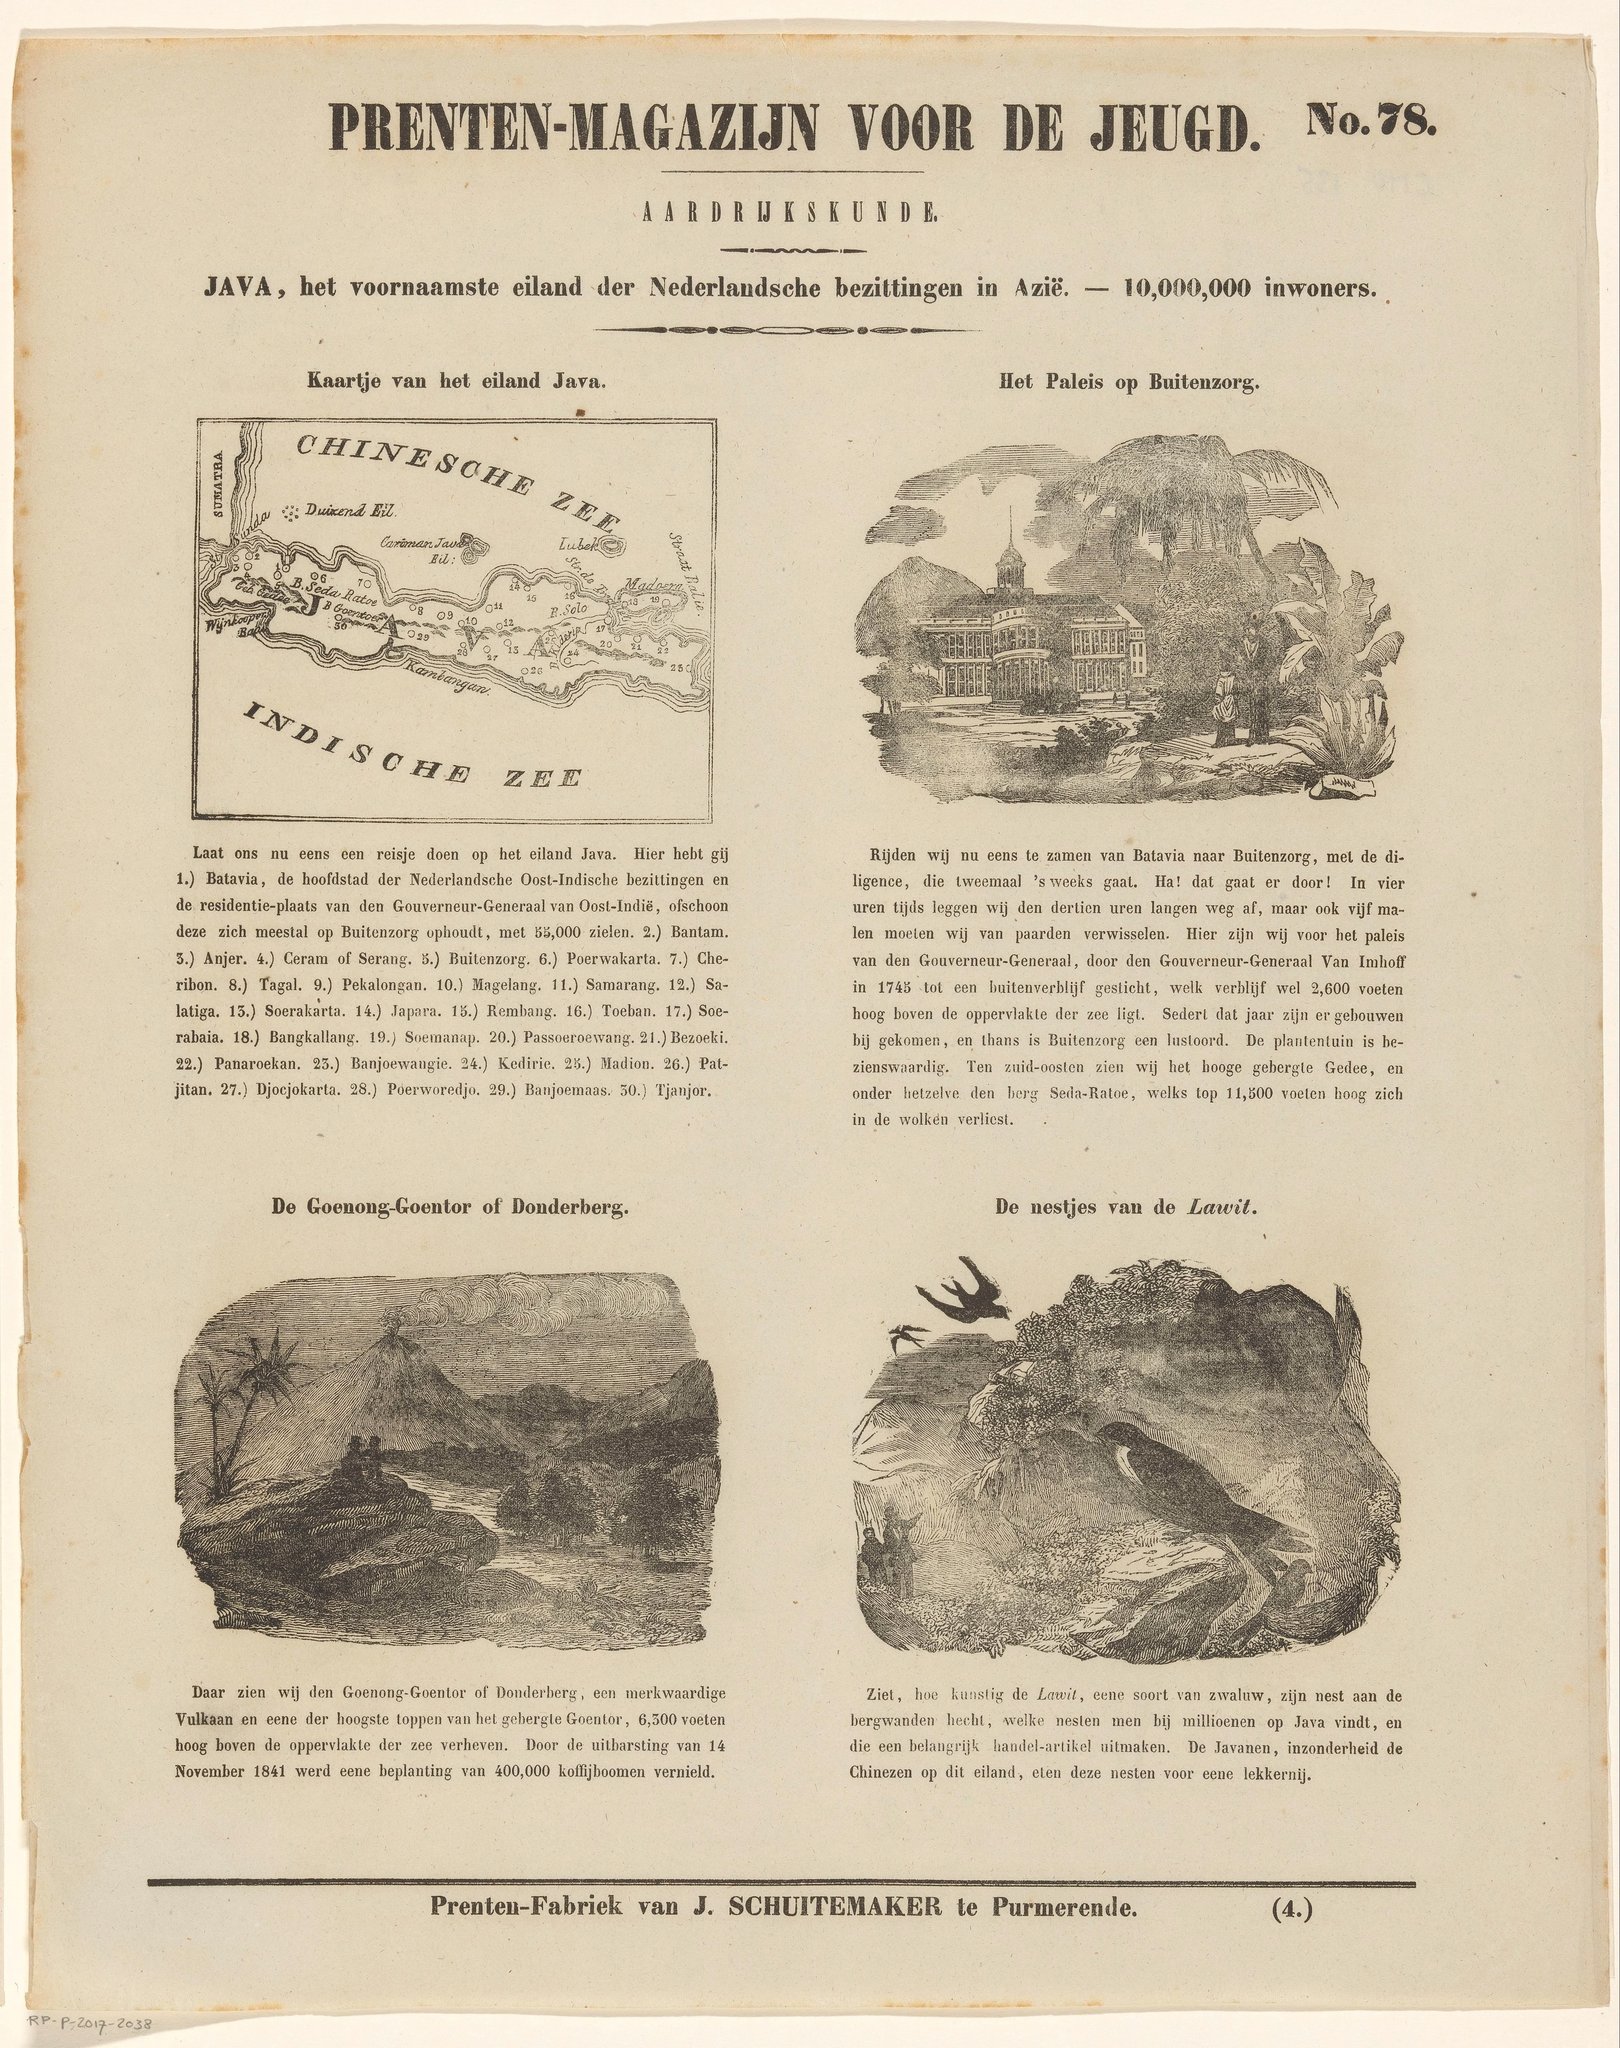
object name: popular print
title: Java, het voornaamste eiland der Nederlandsche bezittingen in Azië. - 10,000,000 inwoners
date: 1850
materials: paper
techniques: letterpress printing, engraving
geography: purmerend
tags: colonial system, birds, maps, atlases, volcano, java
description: Blad met 4 voorstellingen van Java: een kaart, het paleis van de Gouverneur-Generaal in Buitenzorg, de Goenong-Goentor vulkaan en vogels. Boven elke voorstelling een titel en onder elke voorstelling een onderschrift. Genummerd rechtsboven: No. 78, genummerd linksonder: (4.).